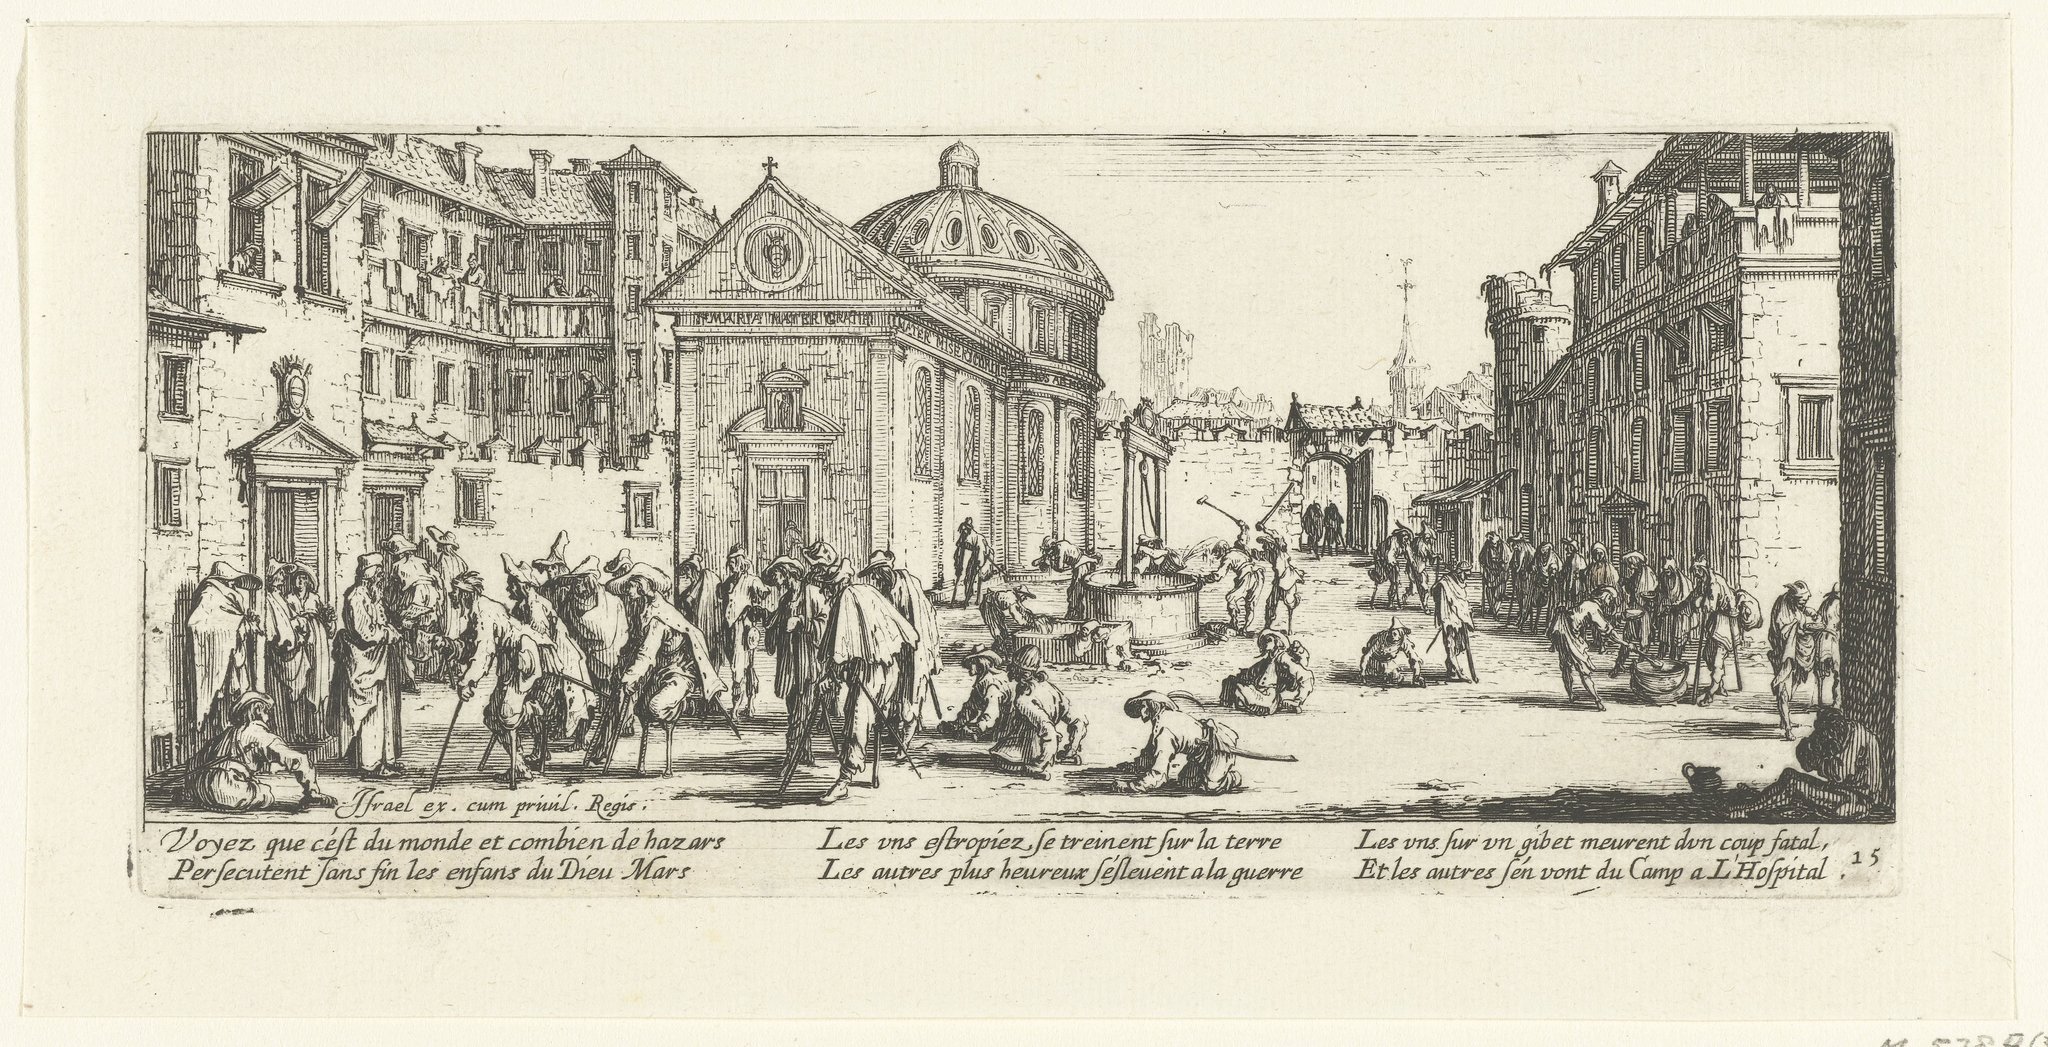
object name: print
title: Gewonden bij een ziekenhuis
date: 1633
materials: paper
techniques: etching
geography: nancy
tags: giving food, crutches, disabled soldier, medical aid and nursing of the sick and wounded in a lazaretto, hospital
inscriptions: collector's mark: Lugt 240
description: Op een plein staan en zitten links verschillende gewonden - oorlogsslachtoffers - te wachten bij de ingang van een ziekenhuis. Rechts staat een aantal mensen op krukken in de rij bij een man die soep uitdeelt. Onder de voorstelling een zesregelig Frans vers. Deze prent is onderdeel van een serie van 17 (18 incl. titelprent) prenten met voorstellingen van diverse soorten ellende die oorlogvoering met zich meebrengt.